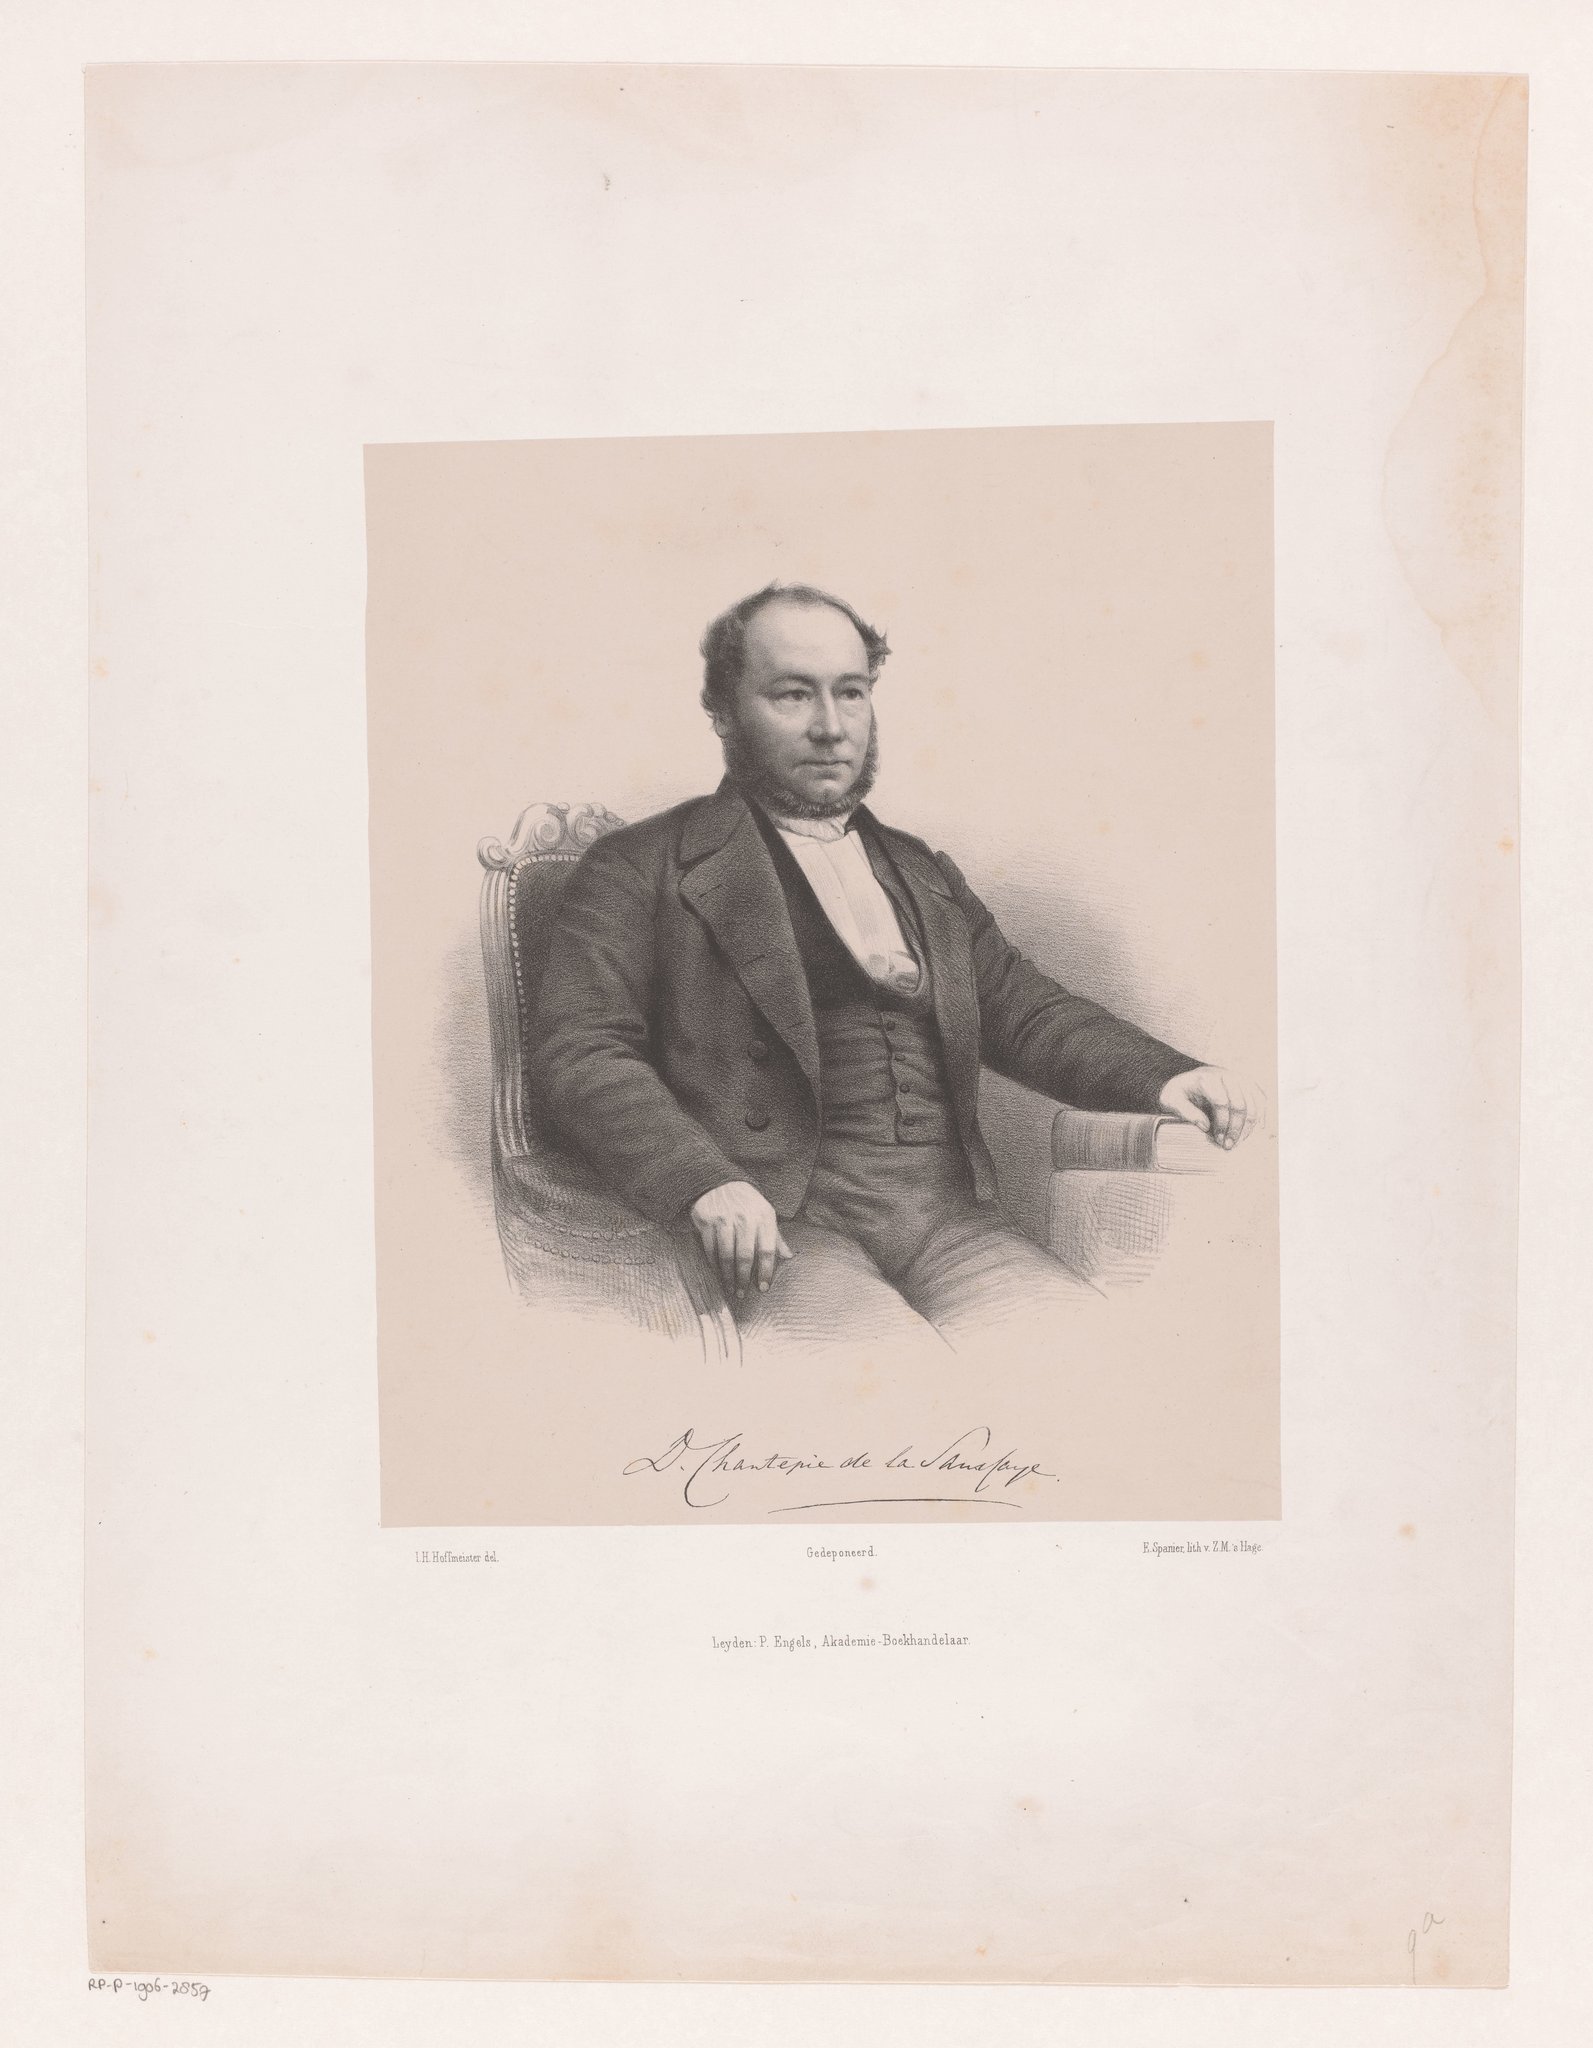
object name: print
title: Portret van Daniel Chantepie de la Saussaye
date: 1851-1874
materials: paper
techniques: lithograph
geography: the hague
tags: historical persons (+ half-length portrait)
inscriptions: collector's mark: Lugt 2228, : ‘Gedeponeerd.’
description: Onder het portret de signatuur van de geportretteerde.